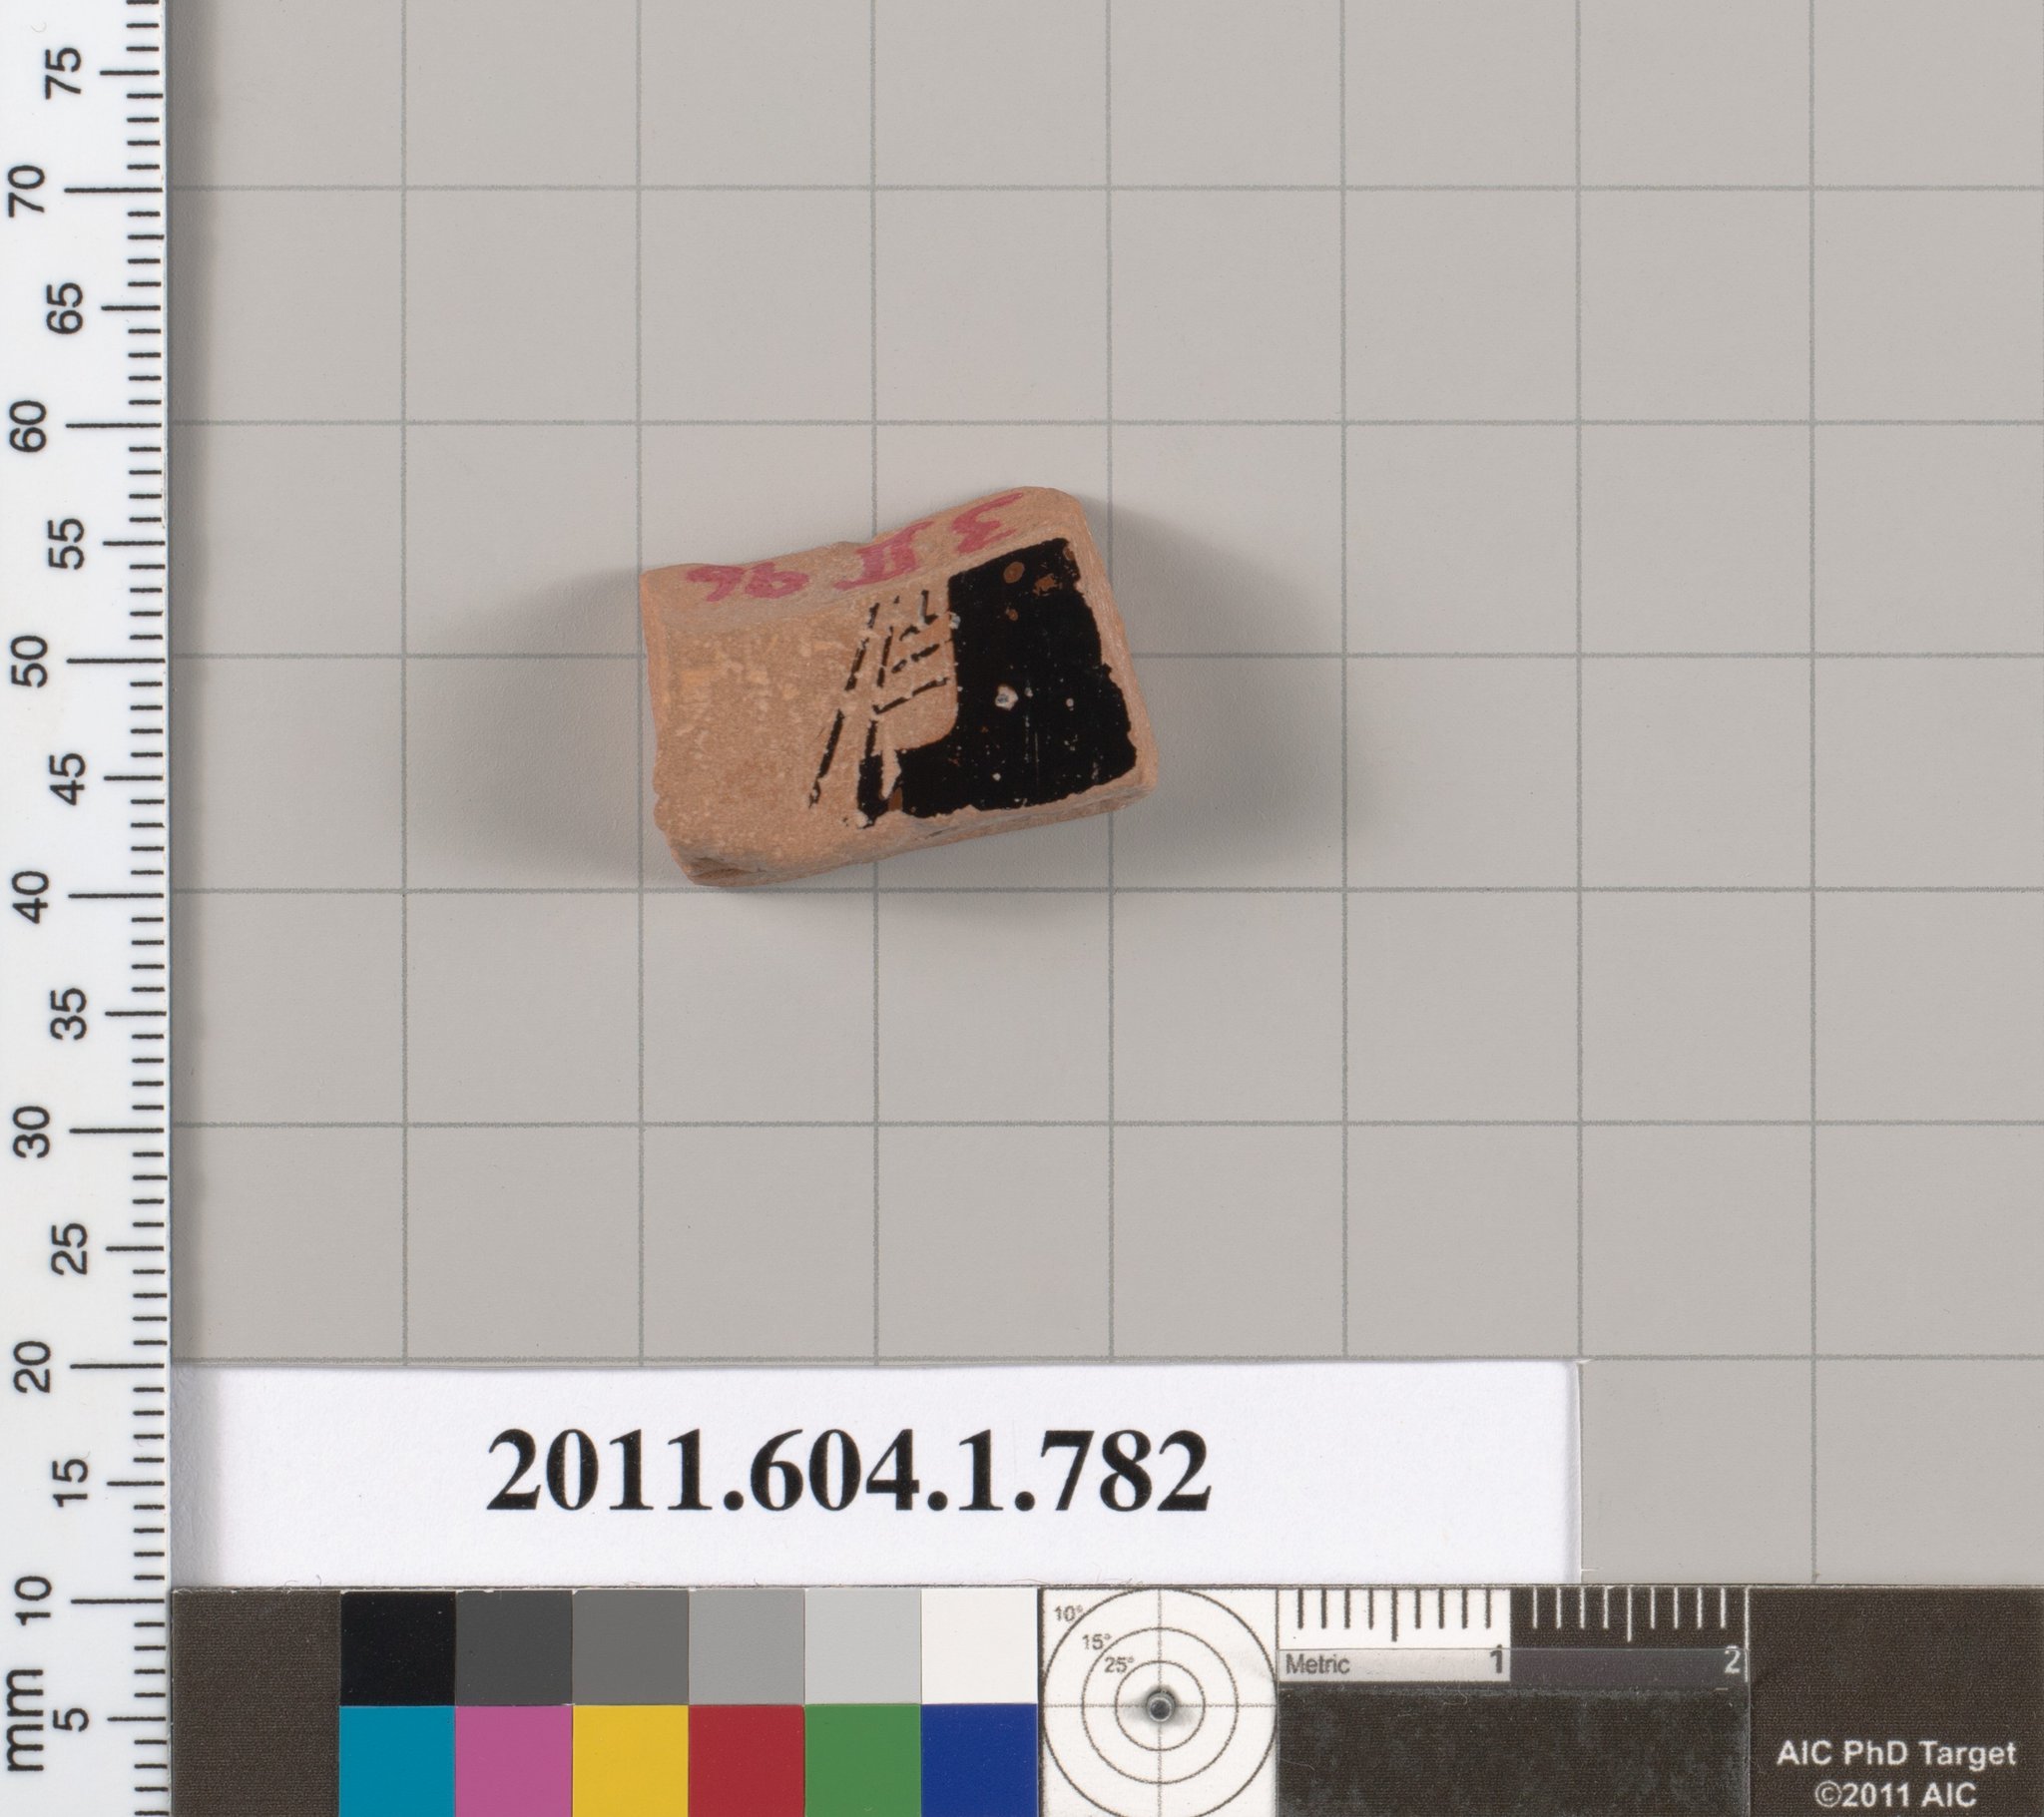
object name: kylix fragment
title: Terracotta fragment of a kylix (drinking cup)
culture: greek, attic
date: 475-451 BCE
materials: terracotta